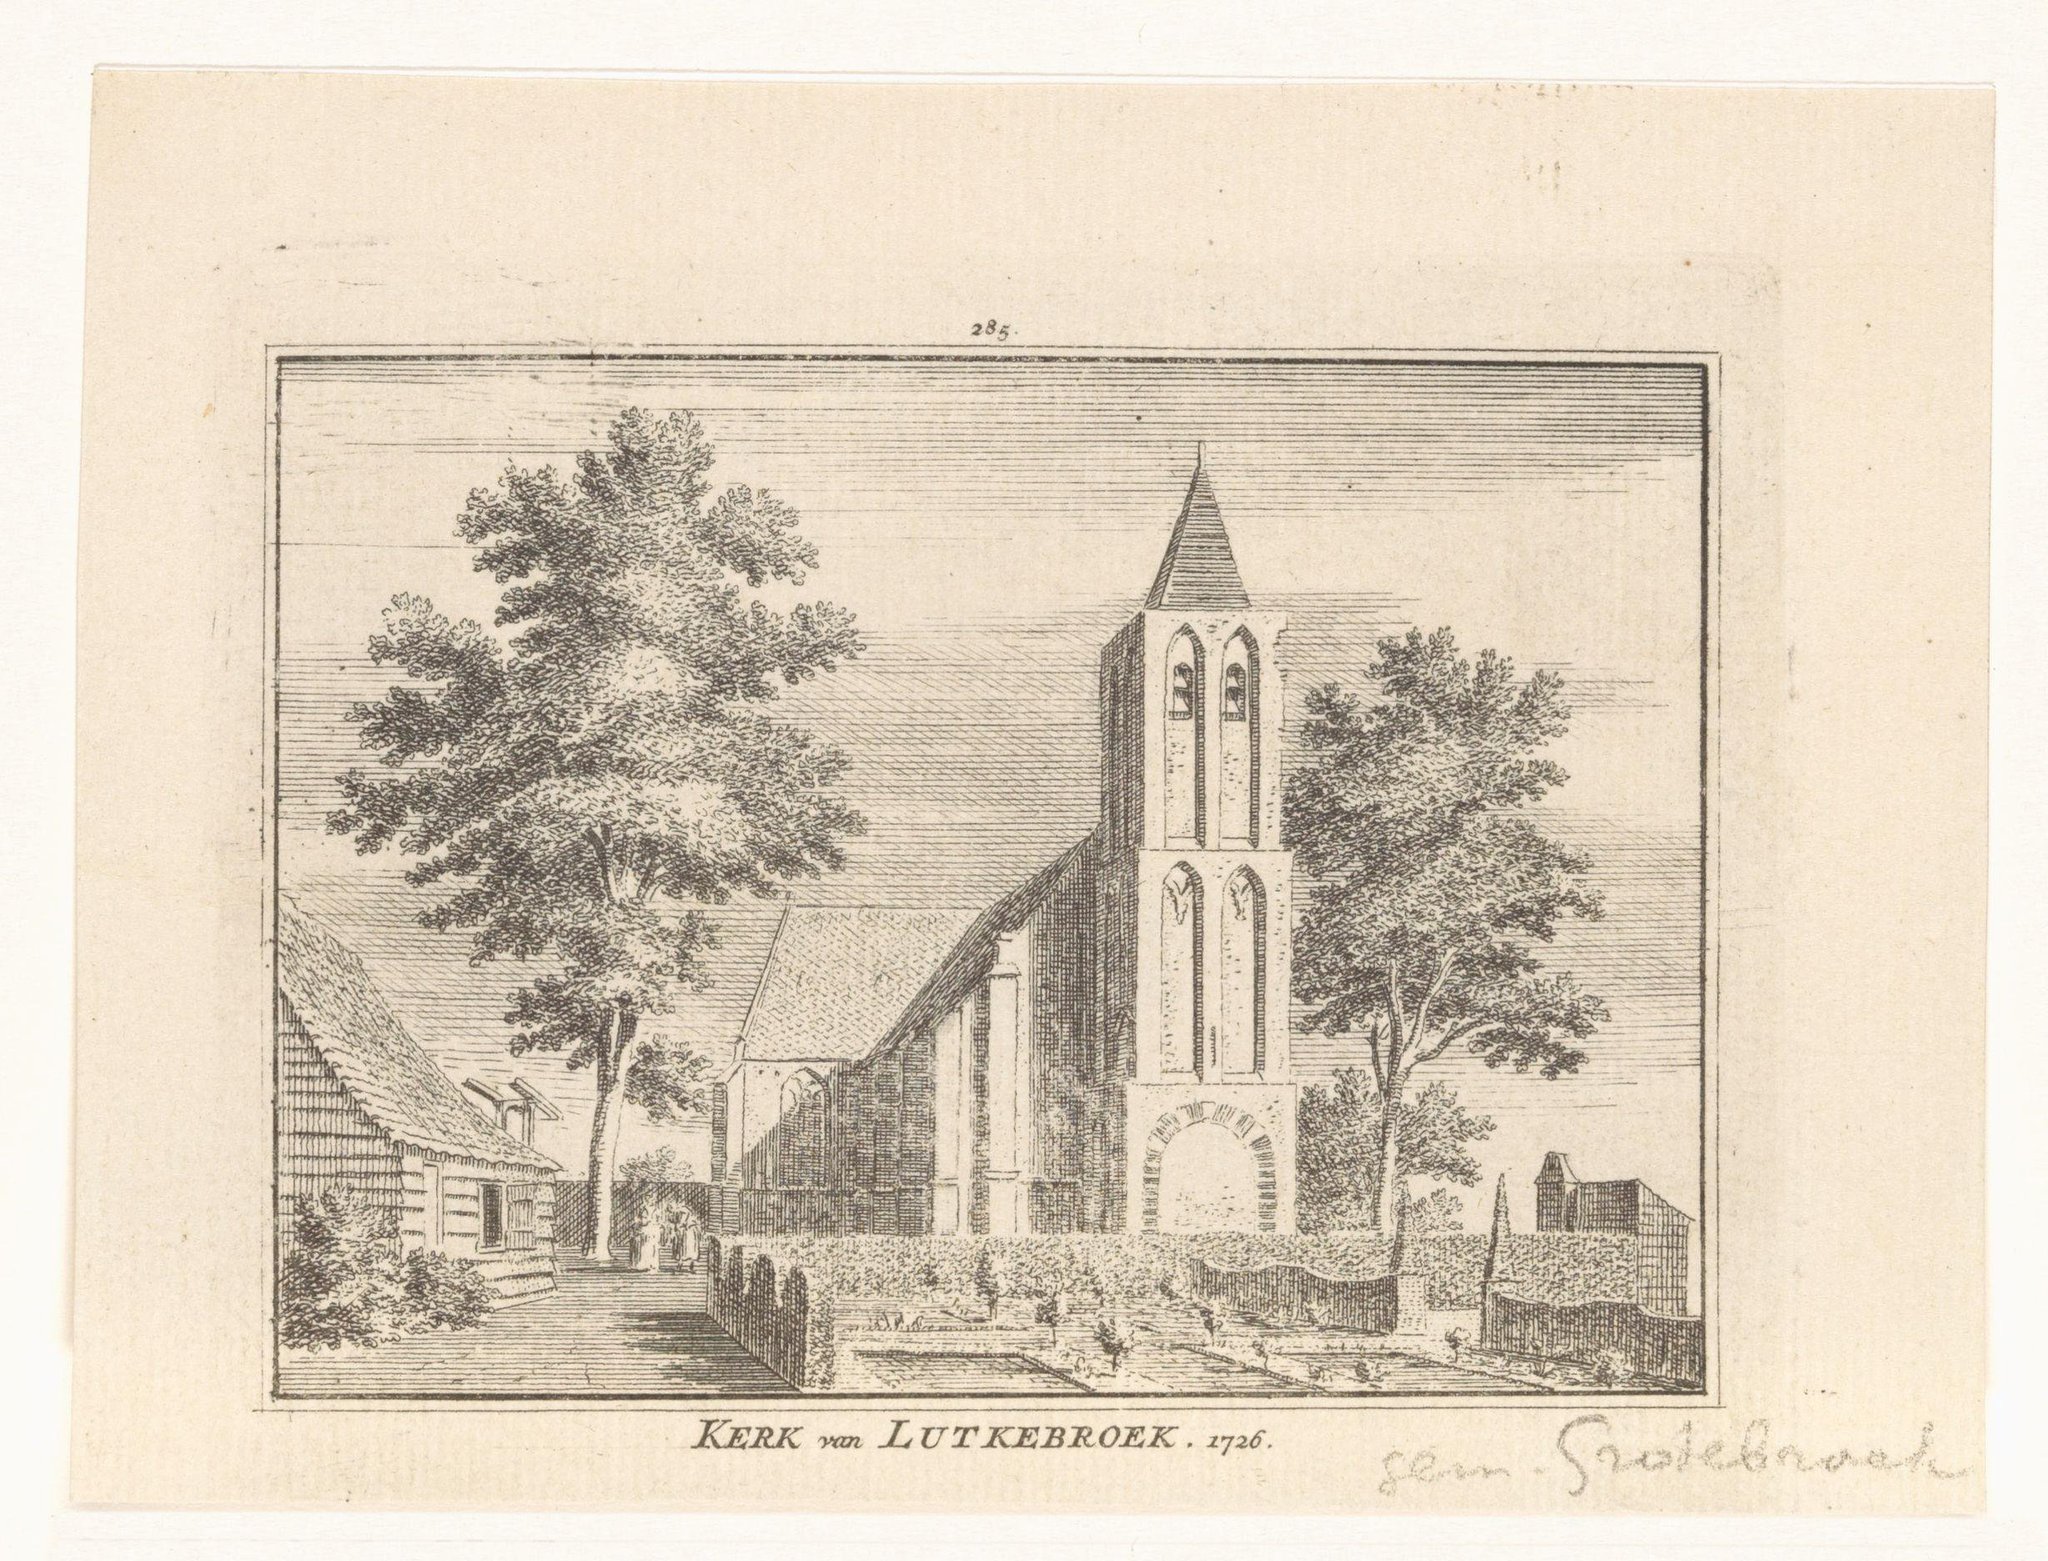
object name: print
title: Kerk te Hensbroek. 1726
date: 1752-1792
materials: paper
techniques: engraving, etching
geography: haarlem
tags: church (exterior)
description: Prent ook gebruikt in: Het verheerlykt Nederland of kabinet van hedendaagsche gezigten van steden, dorpen (…). 9 delen. Amsterdam: Isaak Tirion en weduwe Isaak Tirion, 1745-1774, dl. 4 (1752), ill. 352. Of in: Nederlandsche tafereelen; of eene keurige verzameling van negen honderd fraaije gezigten van steden, dorpen, sloten, oudheden (….). 9 delen. Amsterdam: Jan de Groot, 1792, dl. 4, ill. 352. Uit welke druk het huidige exemplaar precies komt is niet na te gaan.